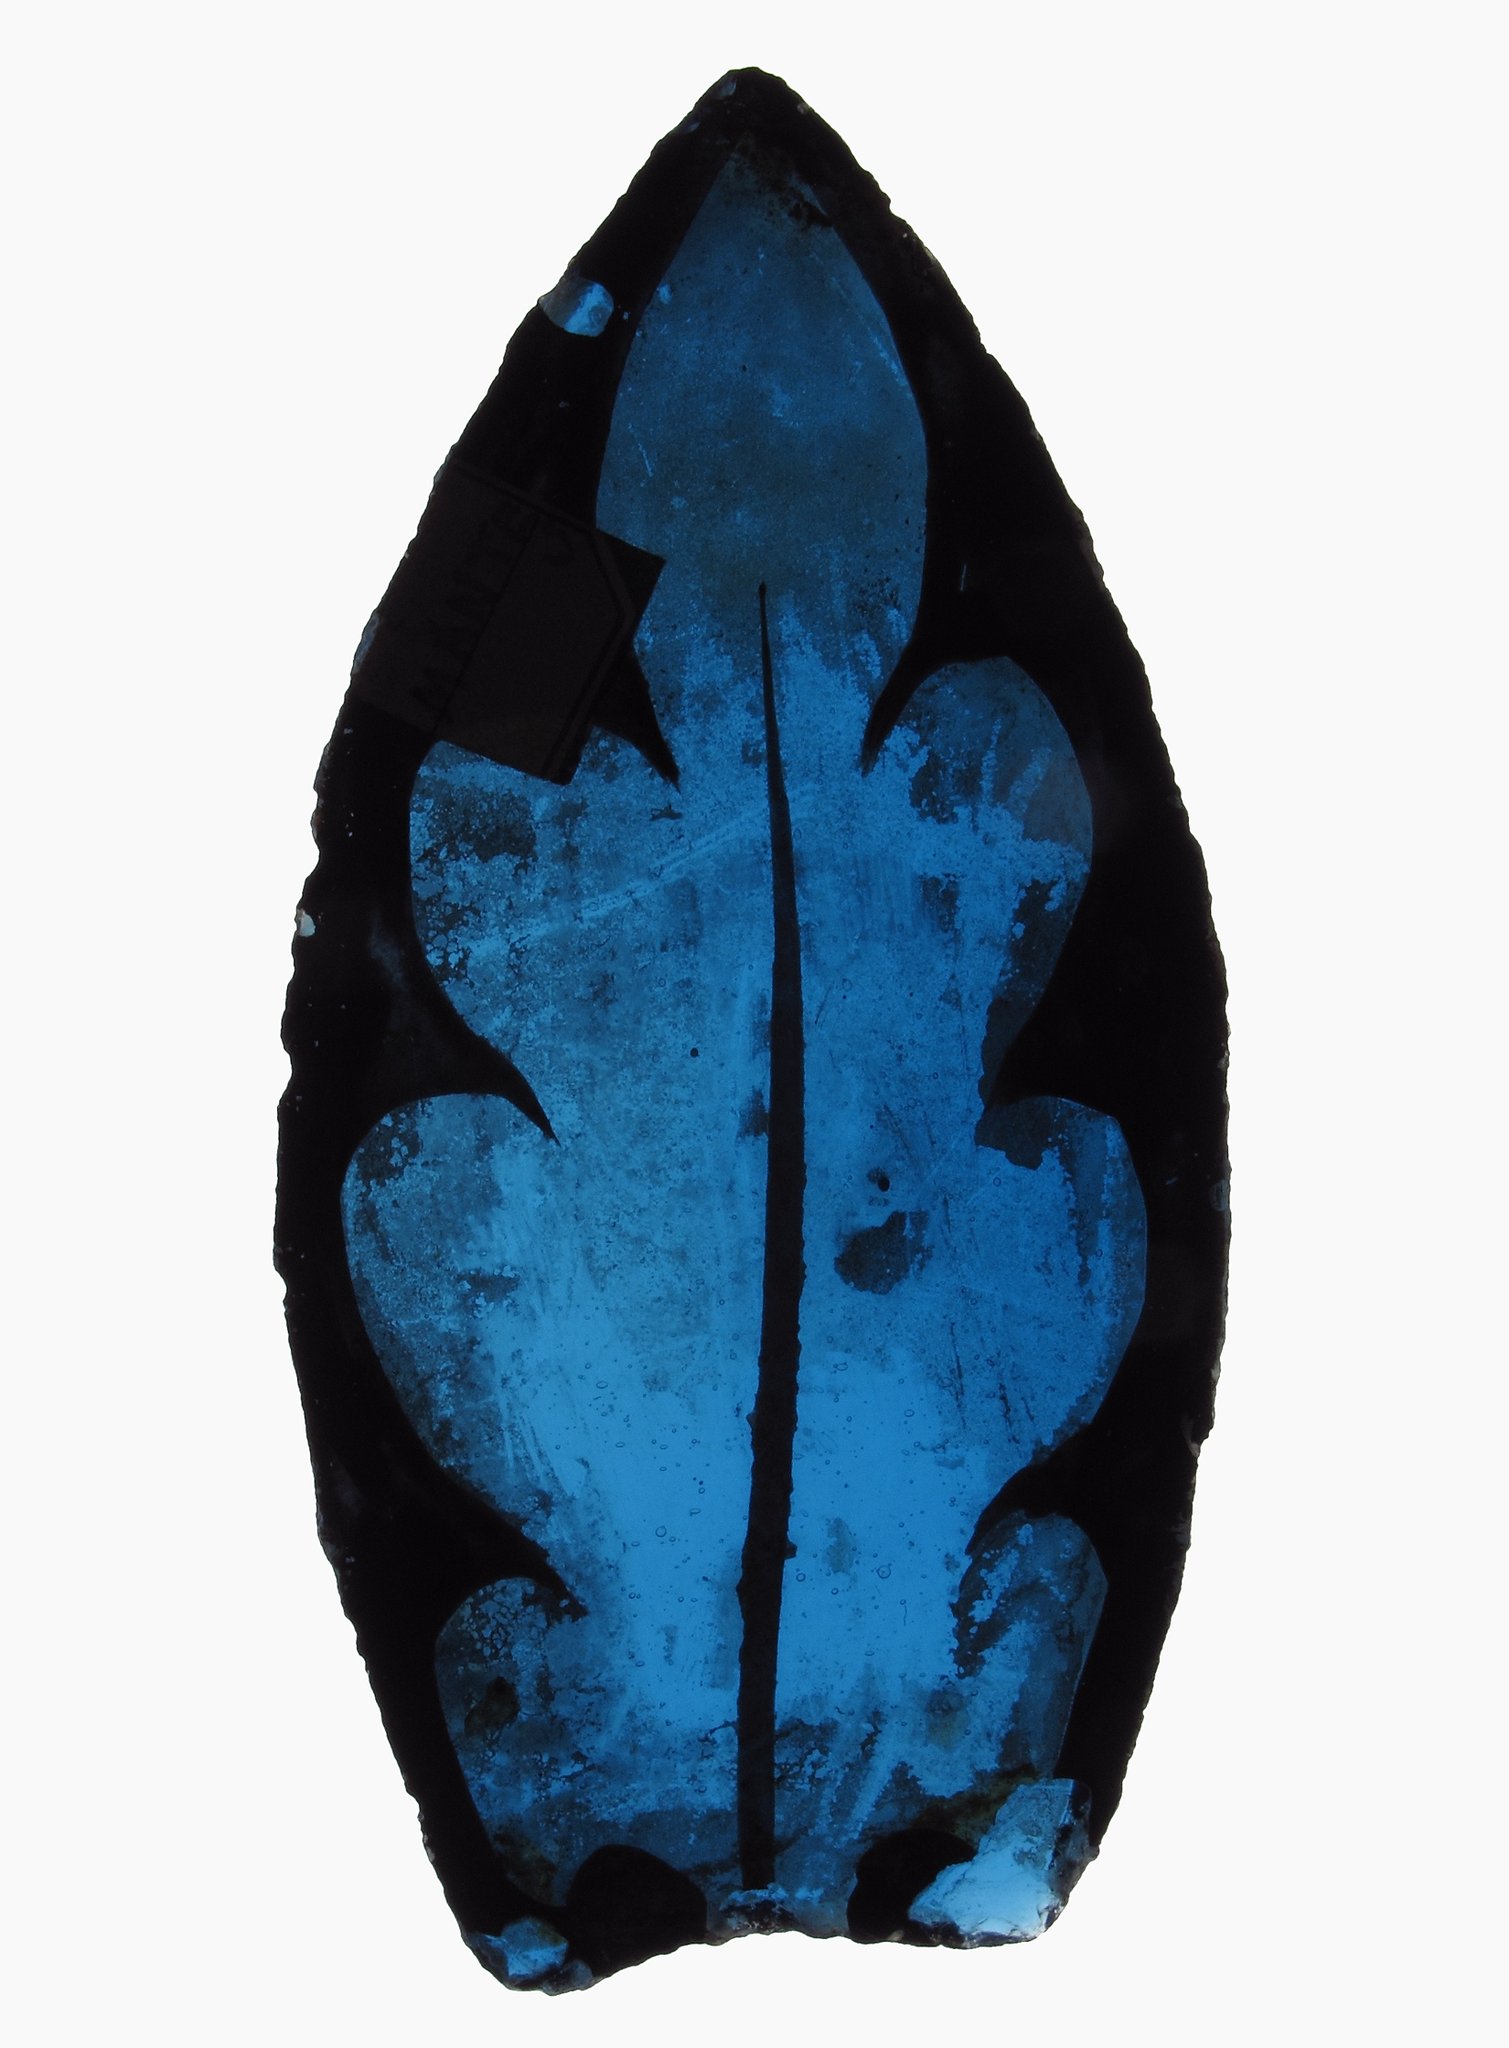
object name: fragment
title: Glass Fragment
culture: european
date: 1201-1300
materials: glass, metal